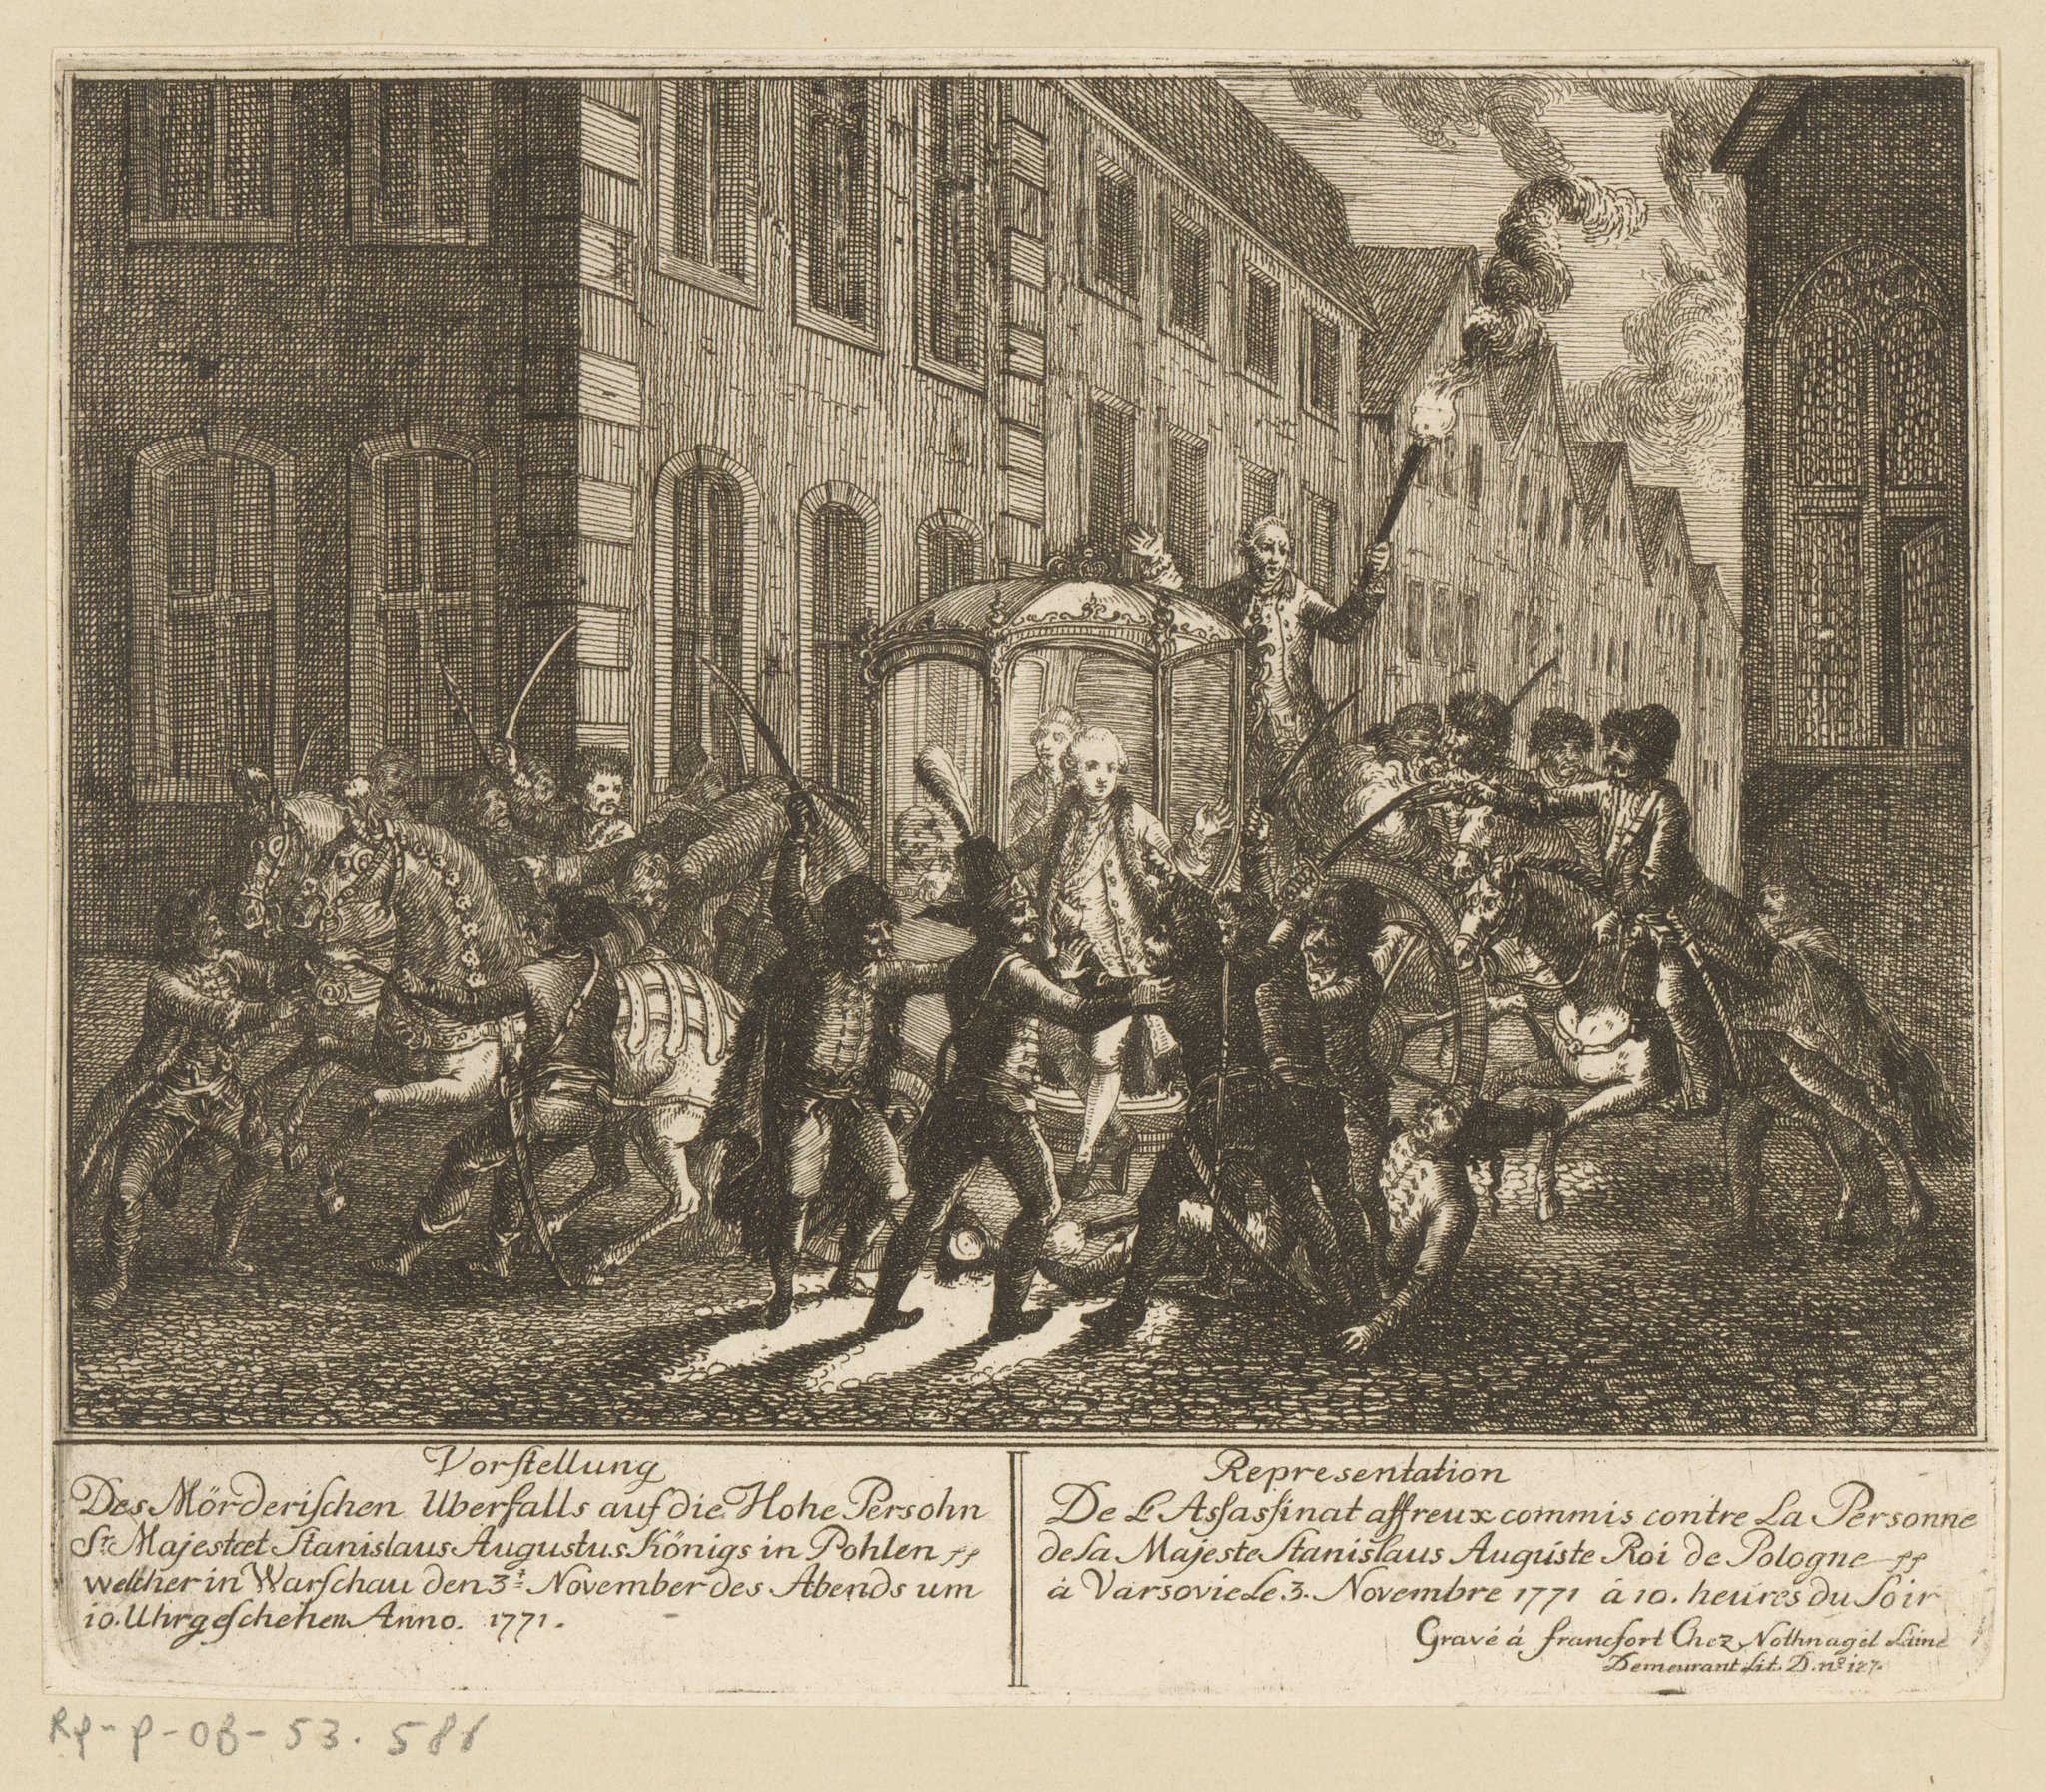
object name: print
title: Moordaanslag op Stanislaus II Augustus Poniatovski, koning van Polen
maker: johann andreas benjamin nothnagel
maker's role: print maker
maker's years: 1729-1804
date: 1771-1804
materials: paper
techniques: etching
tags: attempt, political murder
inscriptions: collector's mark: Lugt 240